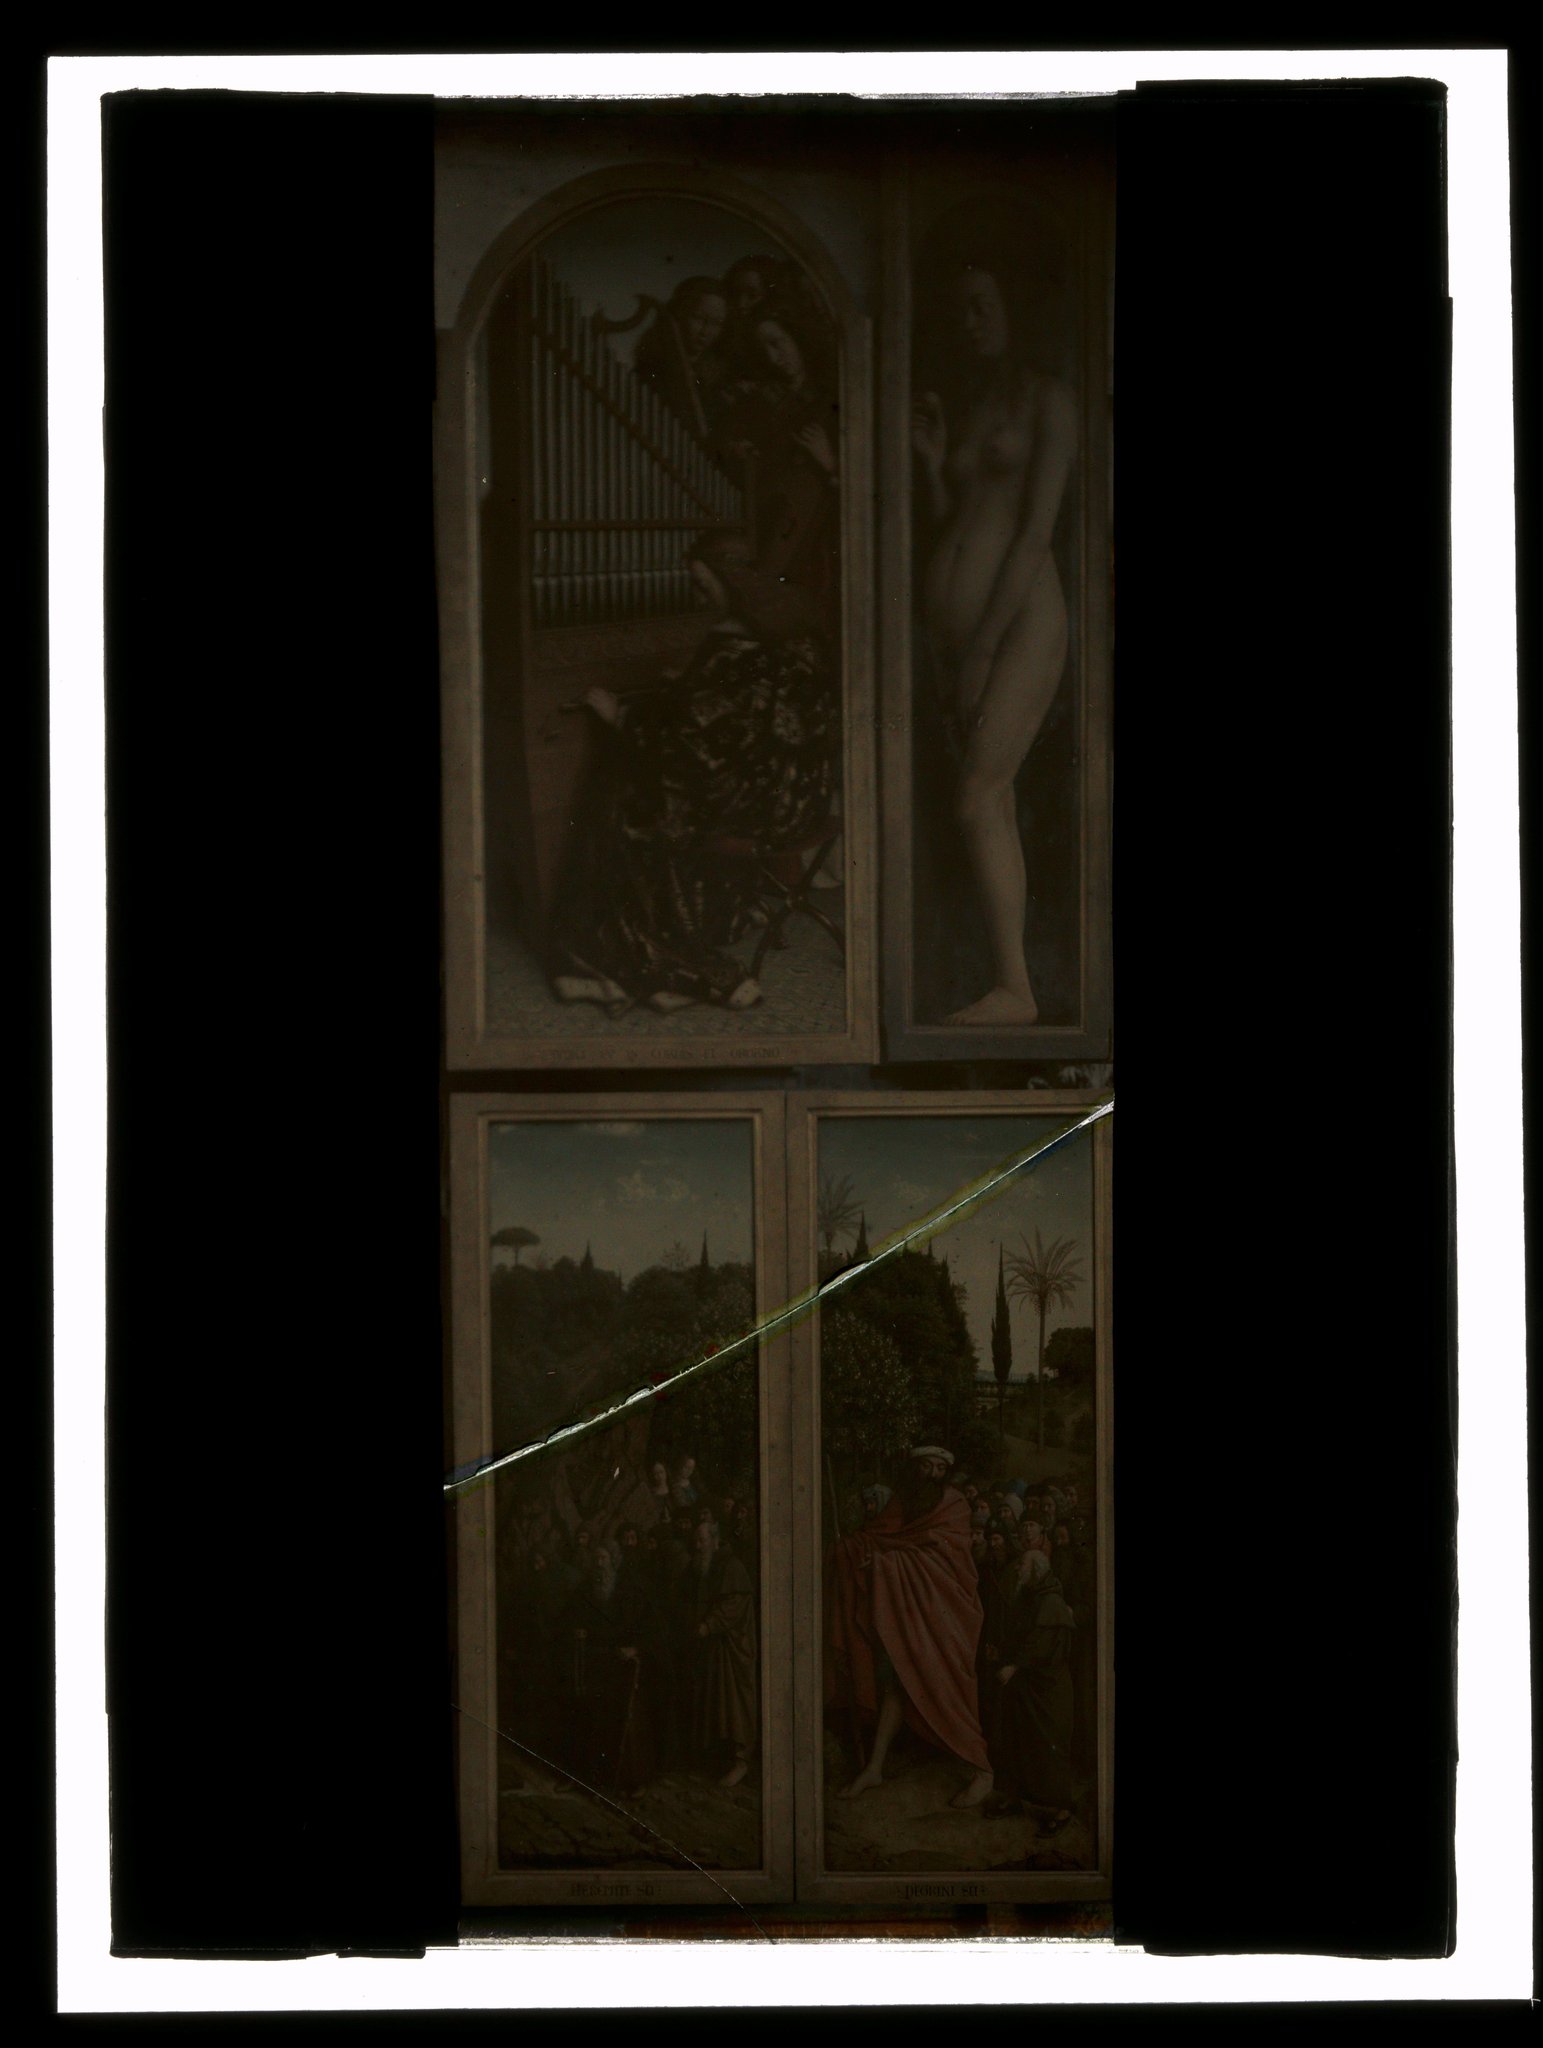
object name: photograph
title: Reproductie (autochroom) van het altaarstuk De aanbidding van het Lam Gods door Hubert en Jan van Eyck, opgesteld in de Sint-Baafskathedraal, Gent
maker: Anonymous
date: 1934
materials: cardboard, glass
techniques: autochrome process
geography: ghent